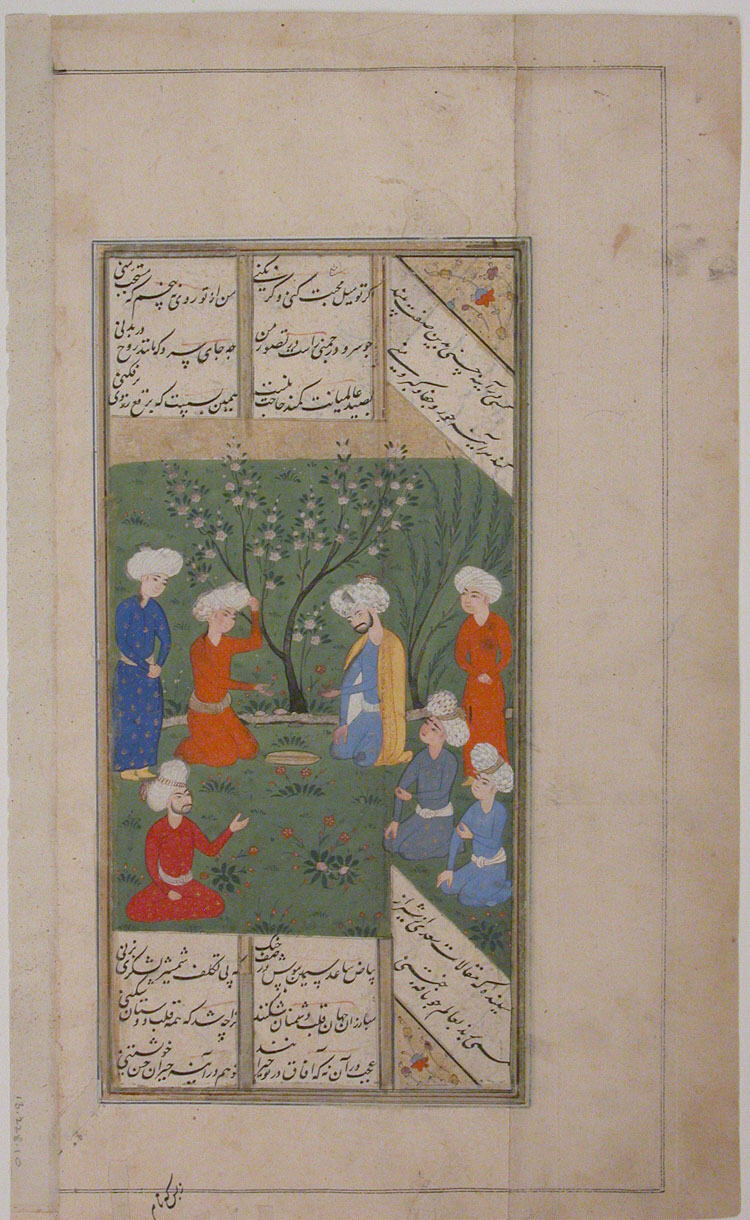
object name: folio from an illustrated manuscript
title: "A Garden Scene", Folio from a Kulliyat (Complete Works) of Sa'di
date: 1801-1900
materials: gold, ink, paper, watercolor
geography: india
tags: gardens,men,women